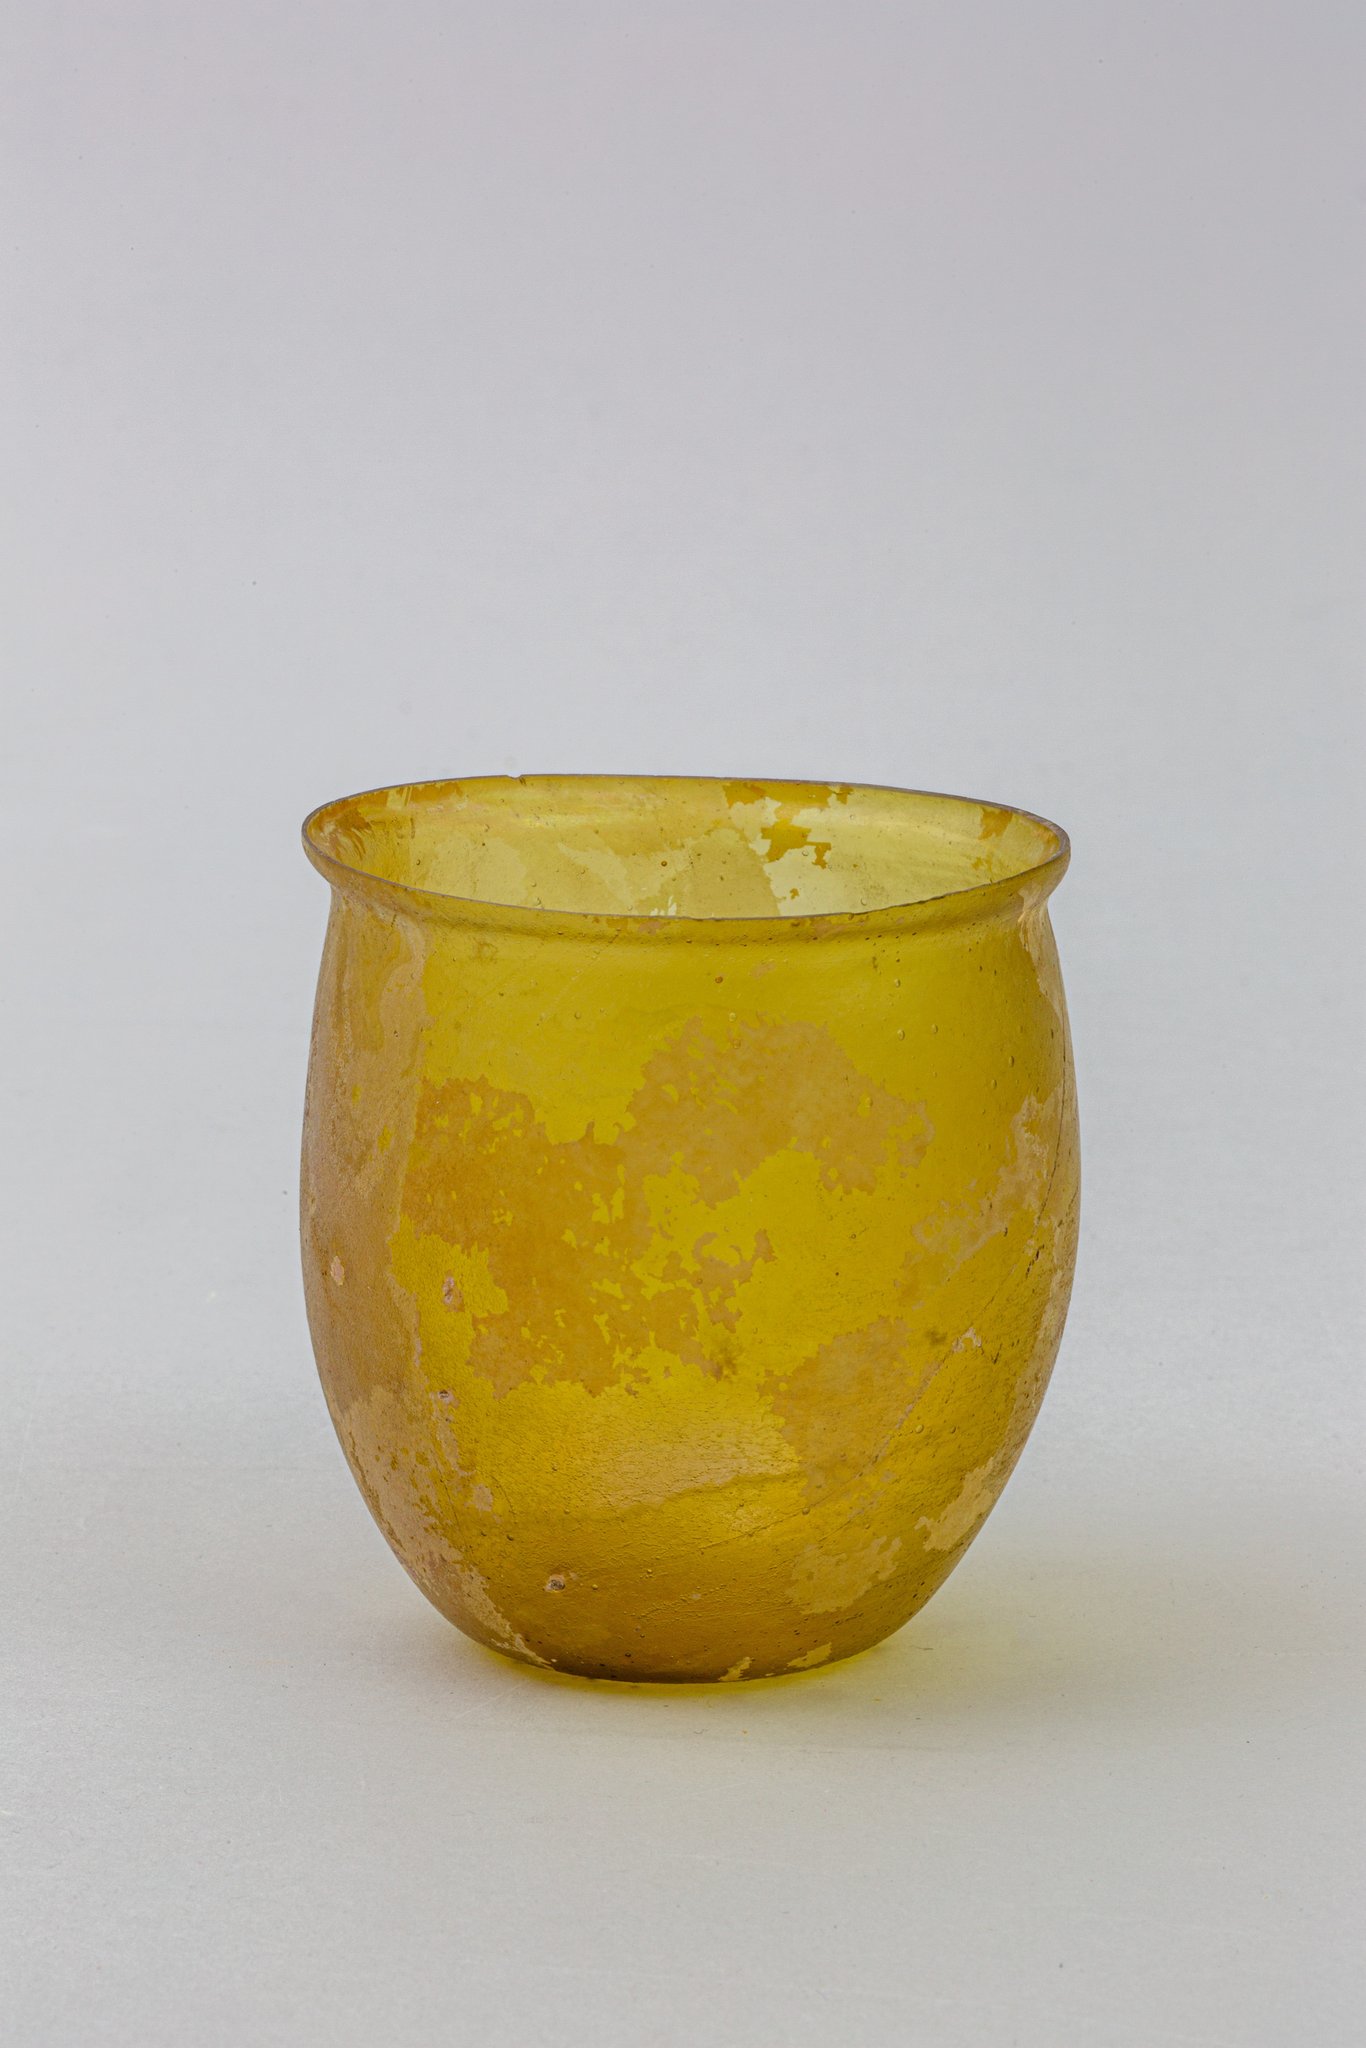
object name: beaker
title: Glass beaker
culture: roman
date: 34-133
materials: glass